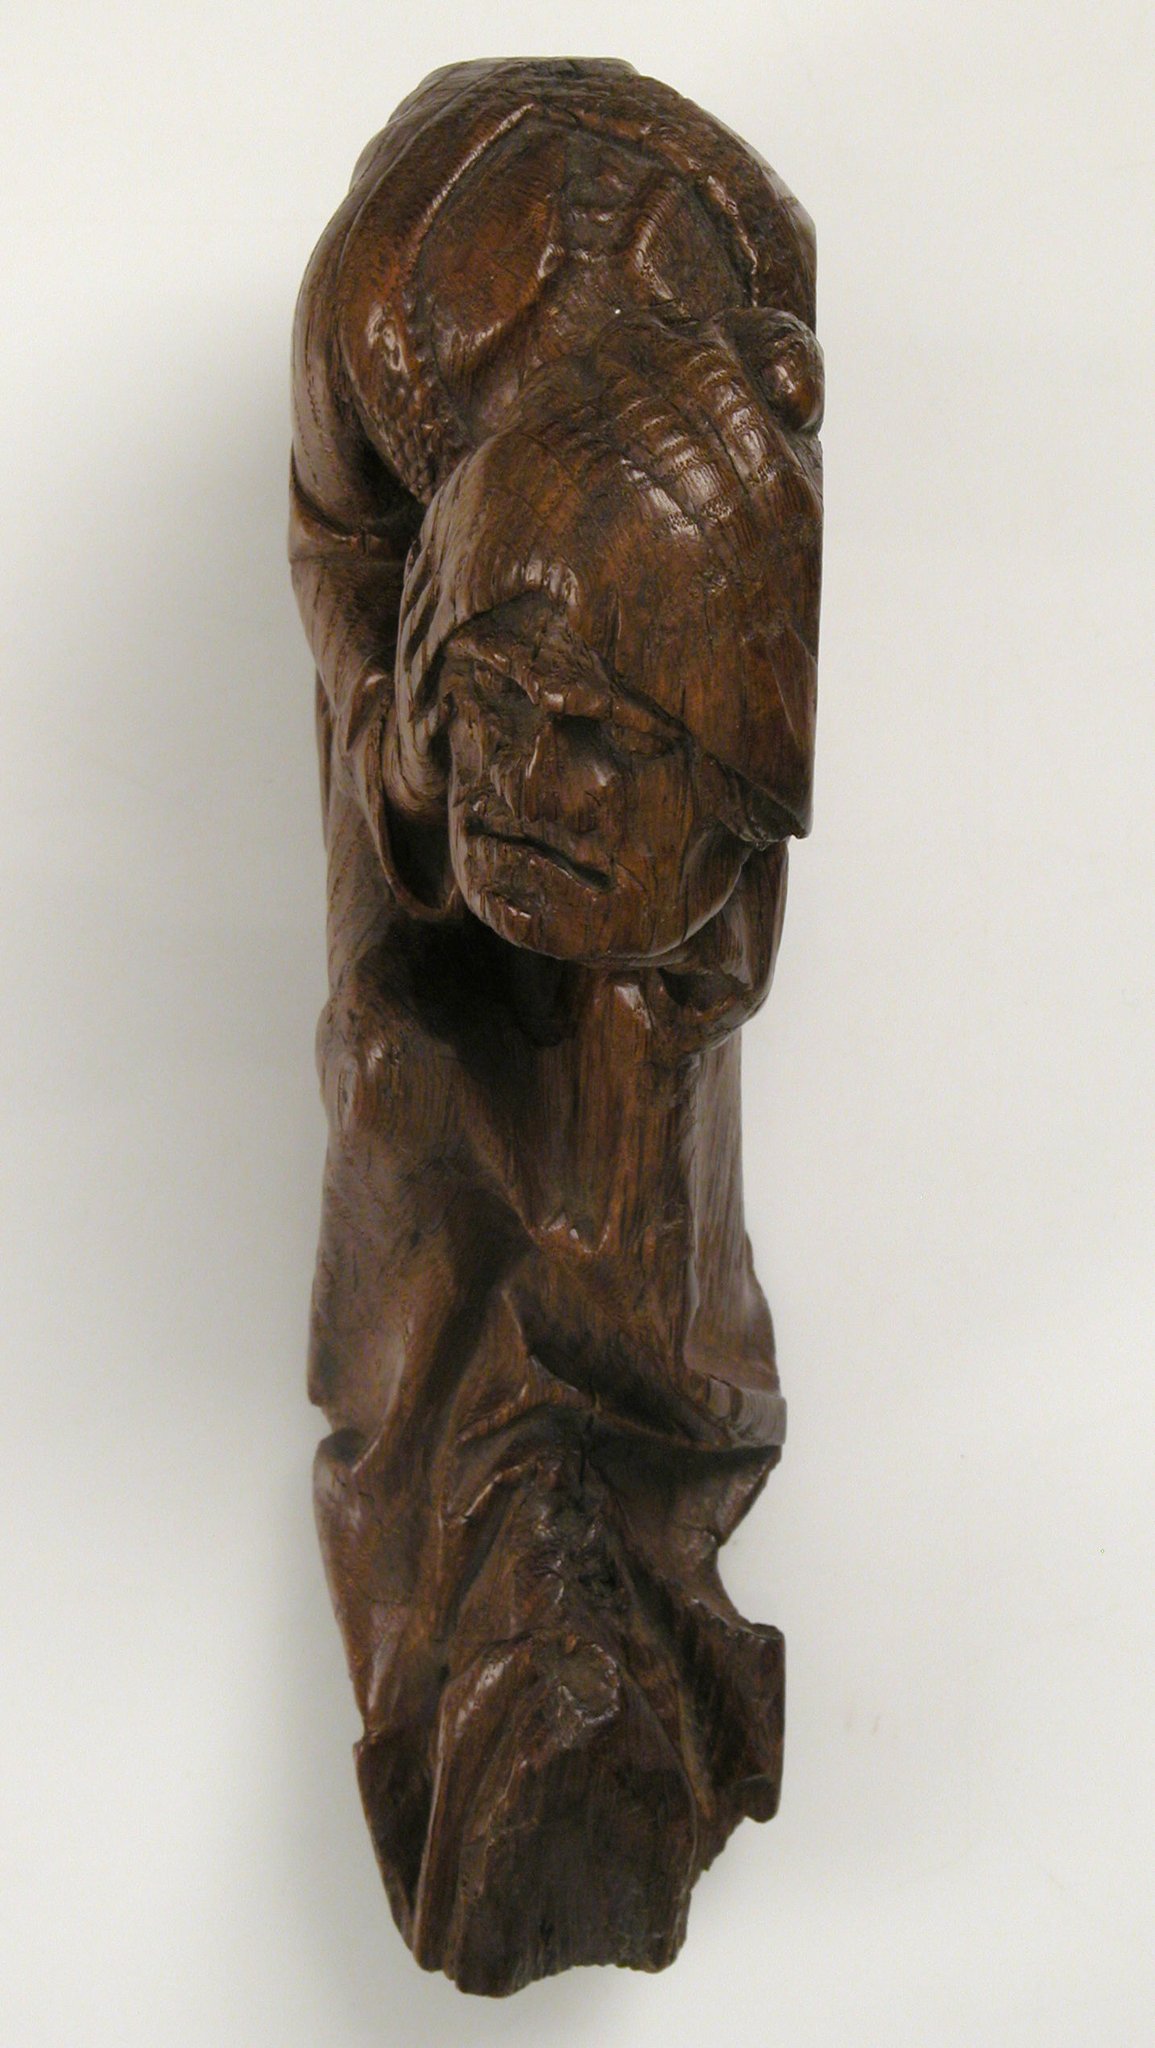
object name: choir stall fragment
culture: franco-netherlandish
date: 1467-1500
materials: wood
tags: heads